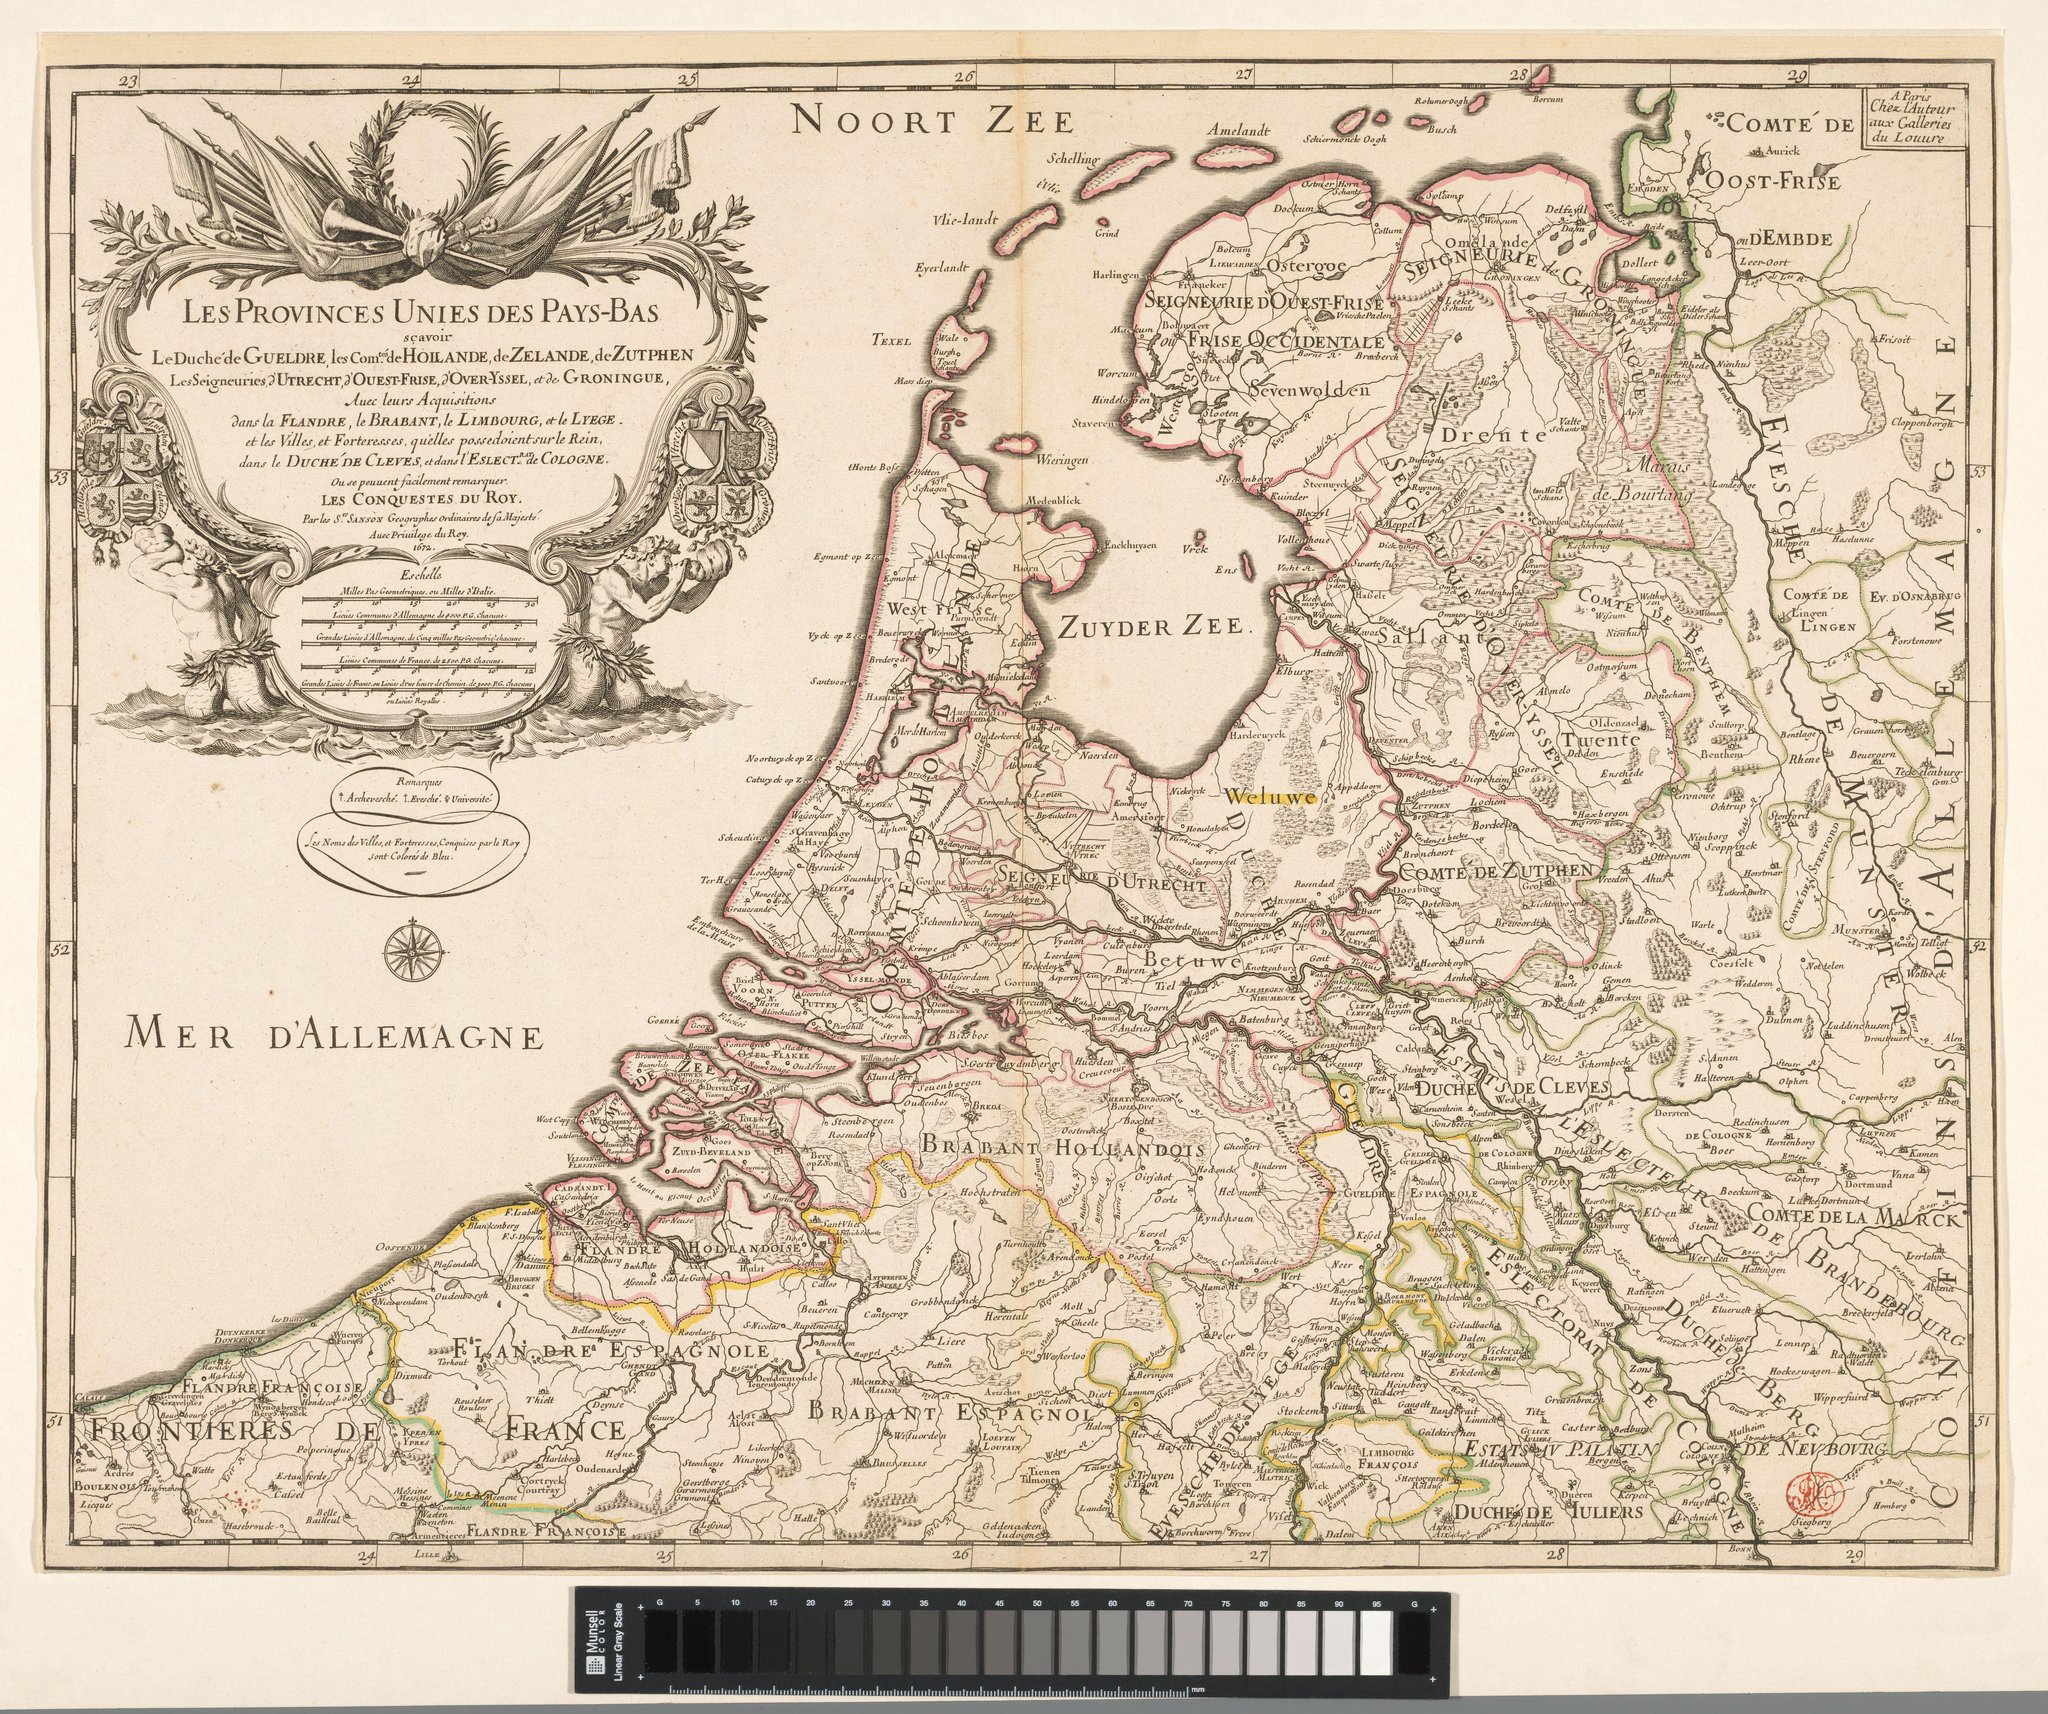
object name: print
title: Les Provinces Unies des Pays-Bas (...) Ou se peuvent facilement remarquer Les Conquestes du roy (...) 1672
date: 1672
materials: paper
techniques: colour, engraving, etching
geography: paris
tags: maps of separate countries or regions, netherlands, rampjaar (disaster year)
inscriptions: collector's mark: Lugt 195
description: Franse kaart van de Republiek der Zeven Verenigde Nederlanden waarop de veroveringen van de Franse koning zijn aangegeven. De grenslijnen zijn met verschillende kleuren aangegeven. Linksboven een grote cartouche met de titel en de wapens van de provincies en tritons.